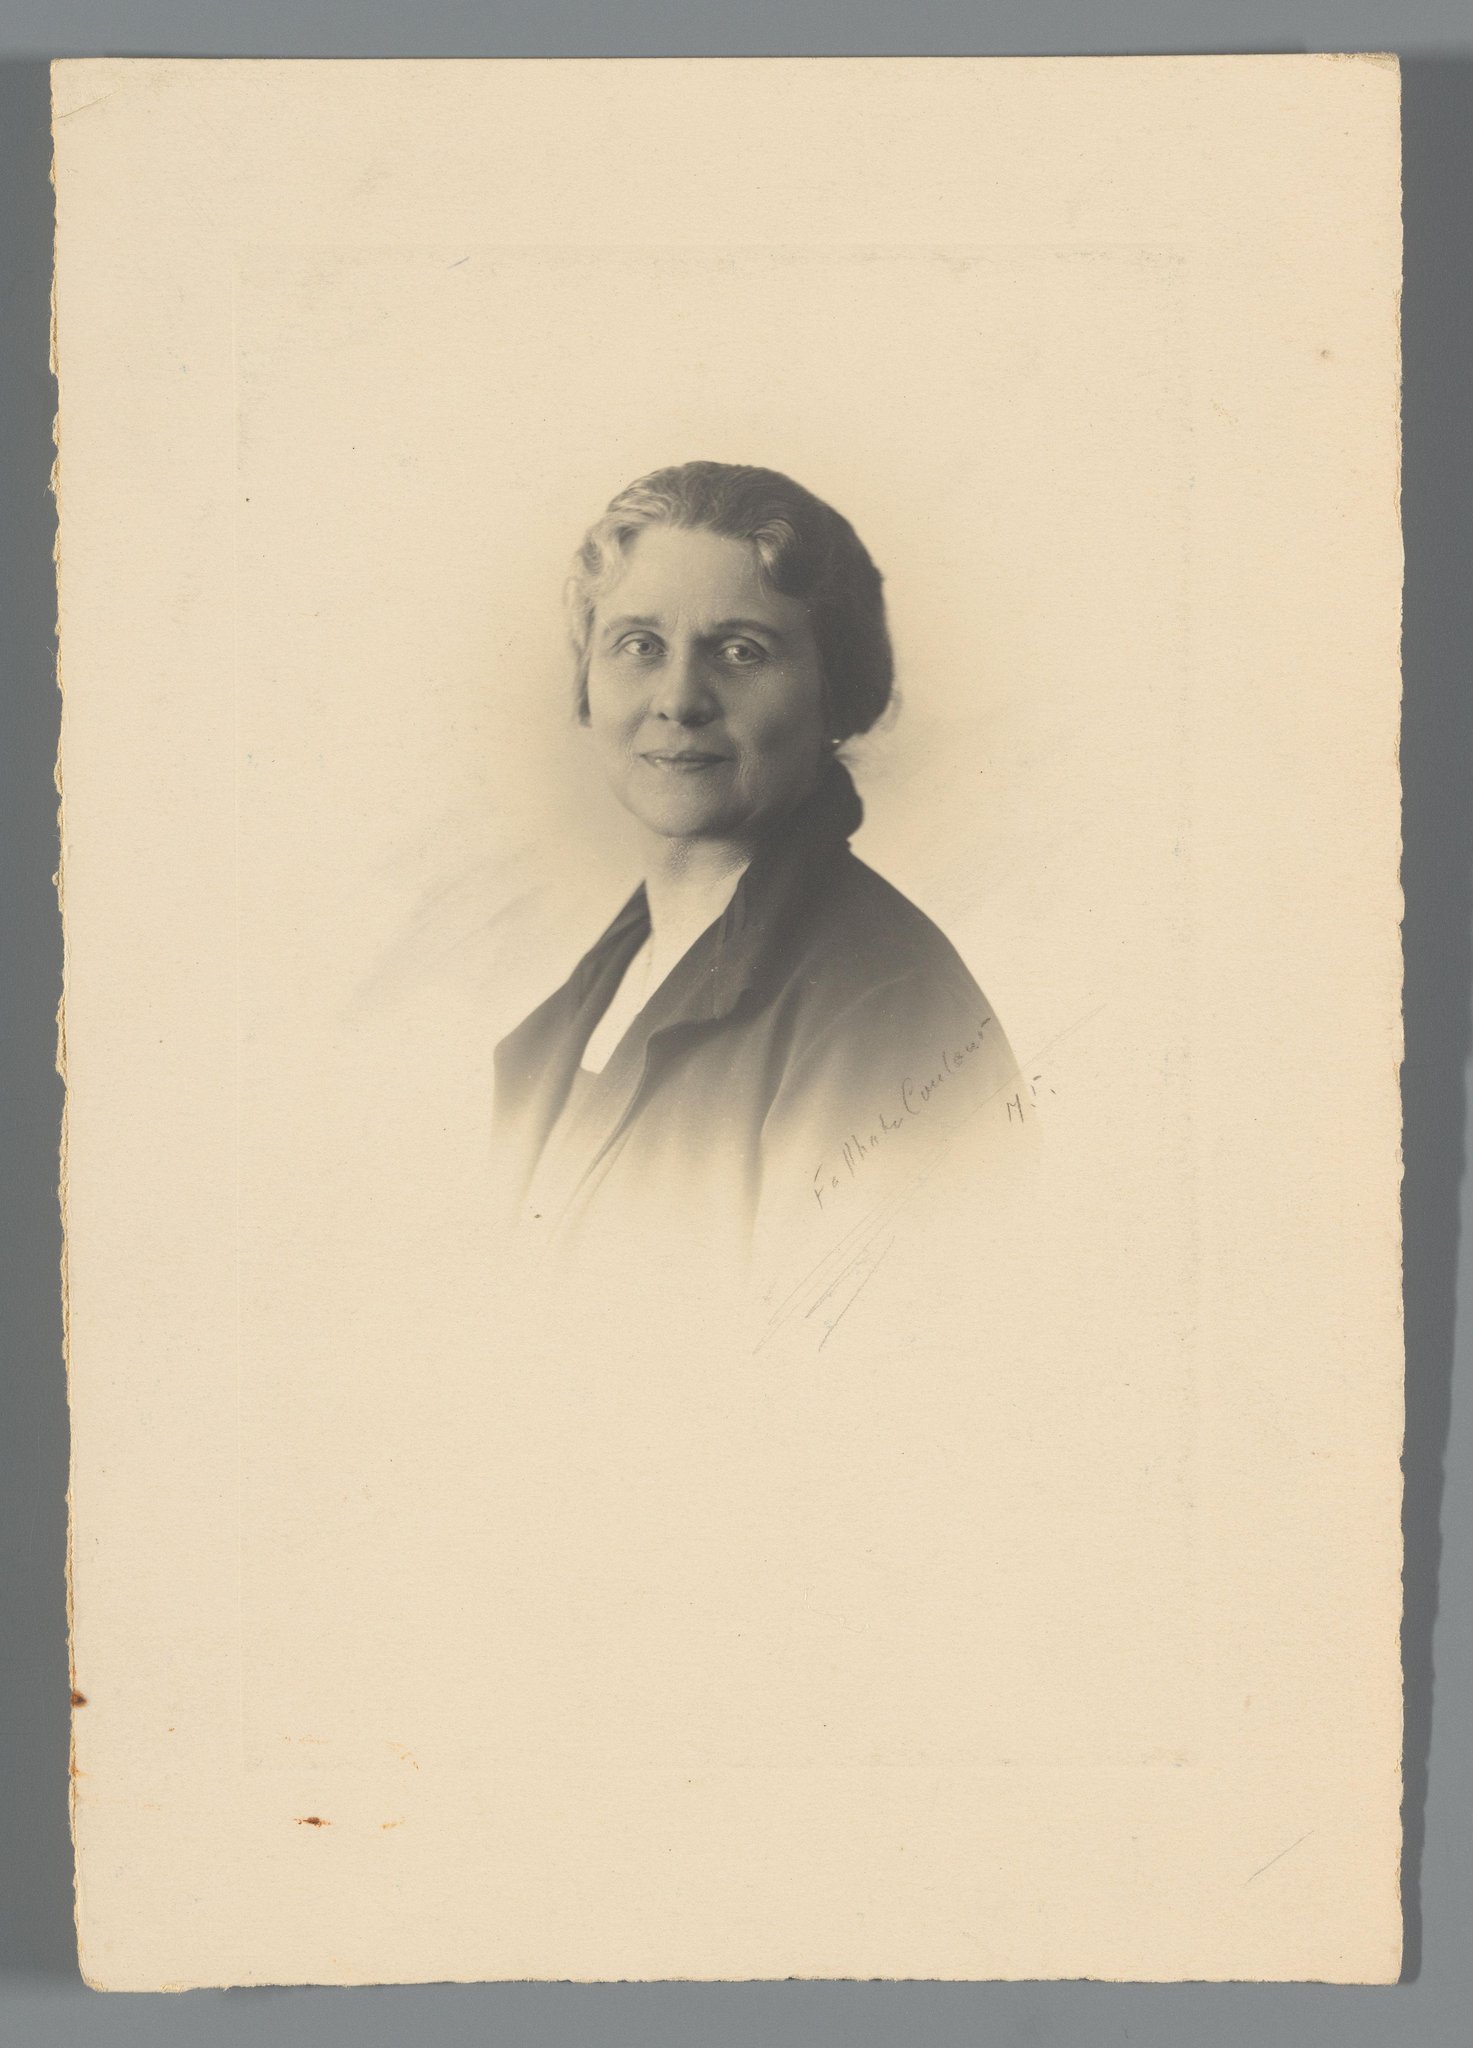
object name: photograph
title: Portret van Line van den Berg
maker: Anonymous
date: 1921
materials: photographic support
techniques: gelatin silver print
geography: netherlands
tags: caroline louise van den berg-van den berg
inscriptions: inscription: ‘1921’